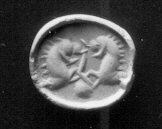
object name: stamp seal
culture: sasanian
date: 201-700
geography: iran or mesopotamia